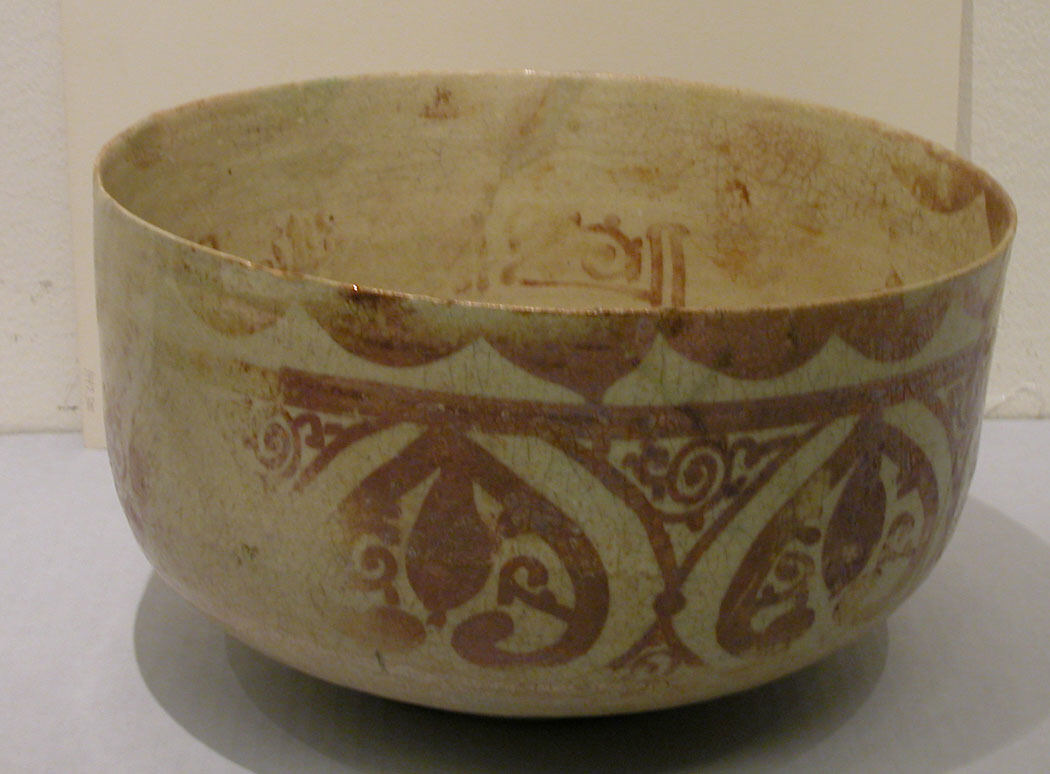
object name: bowl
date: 1134-1166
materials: stonepaste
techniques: luster painting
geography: syria